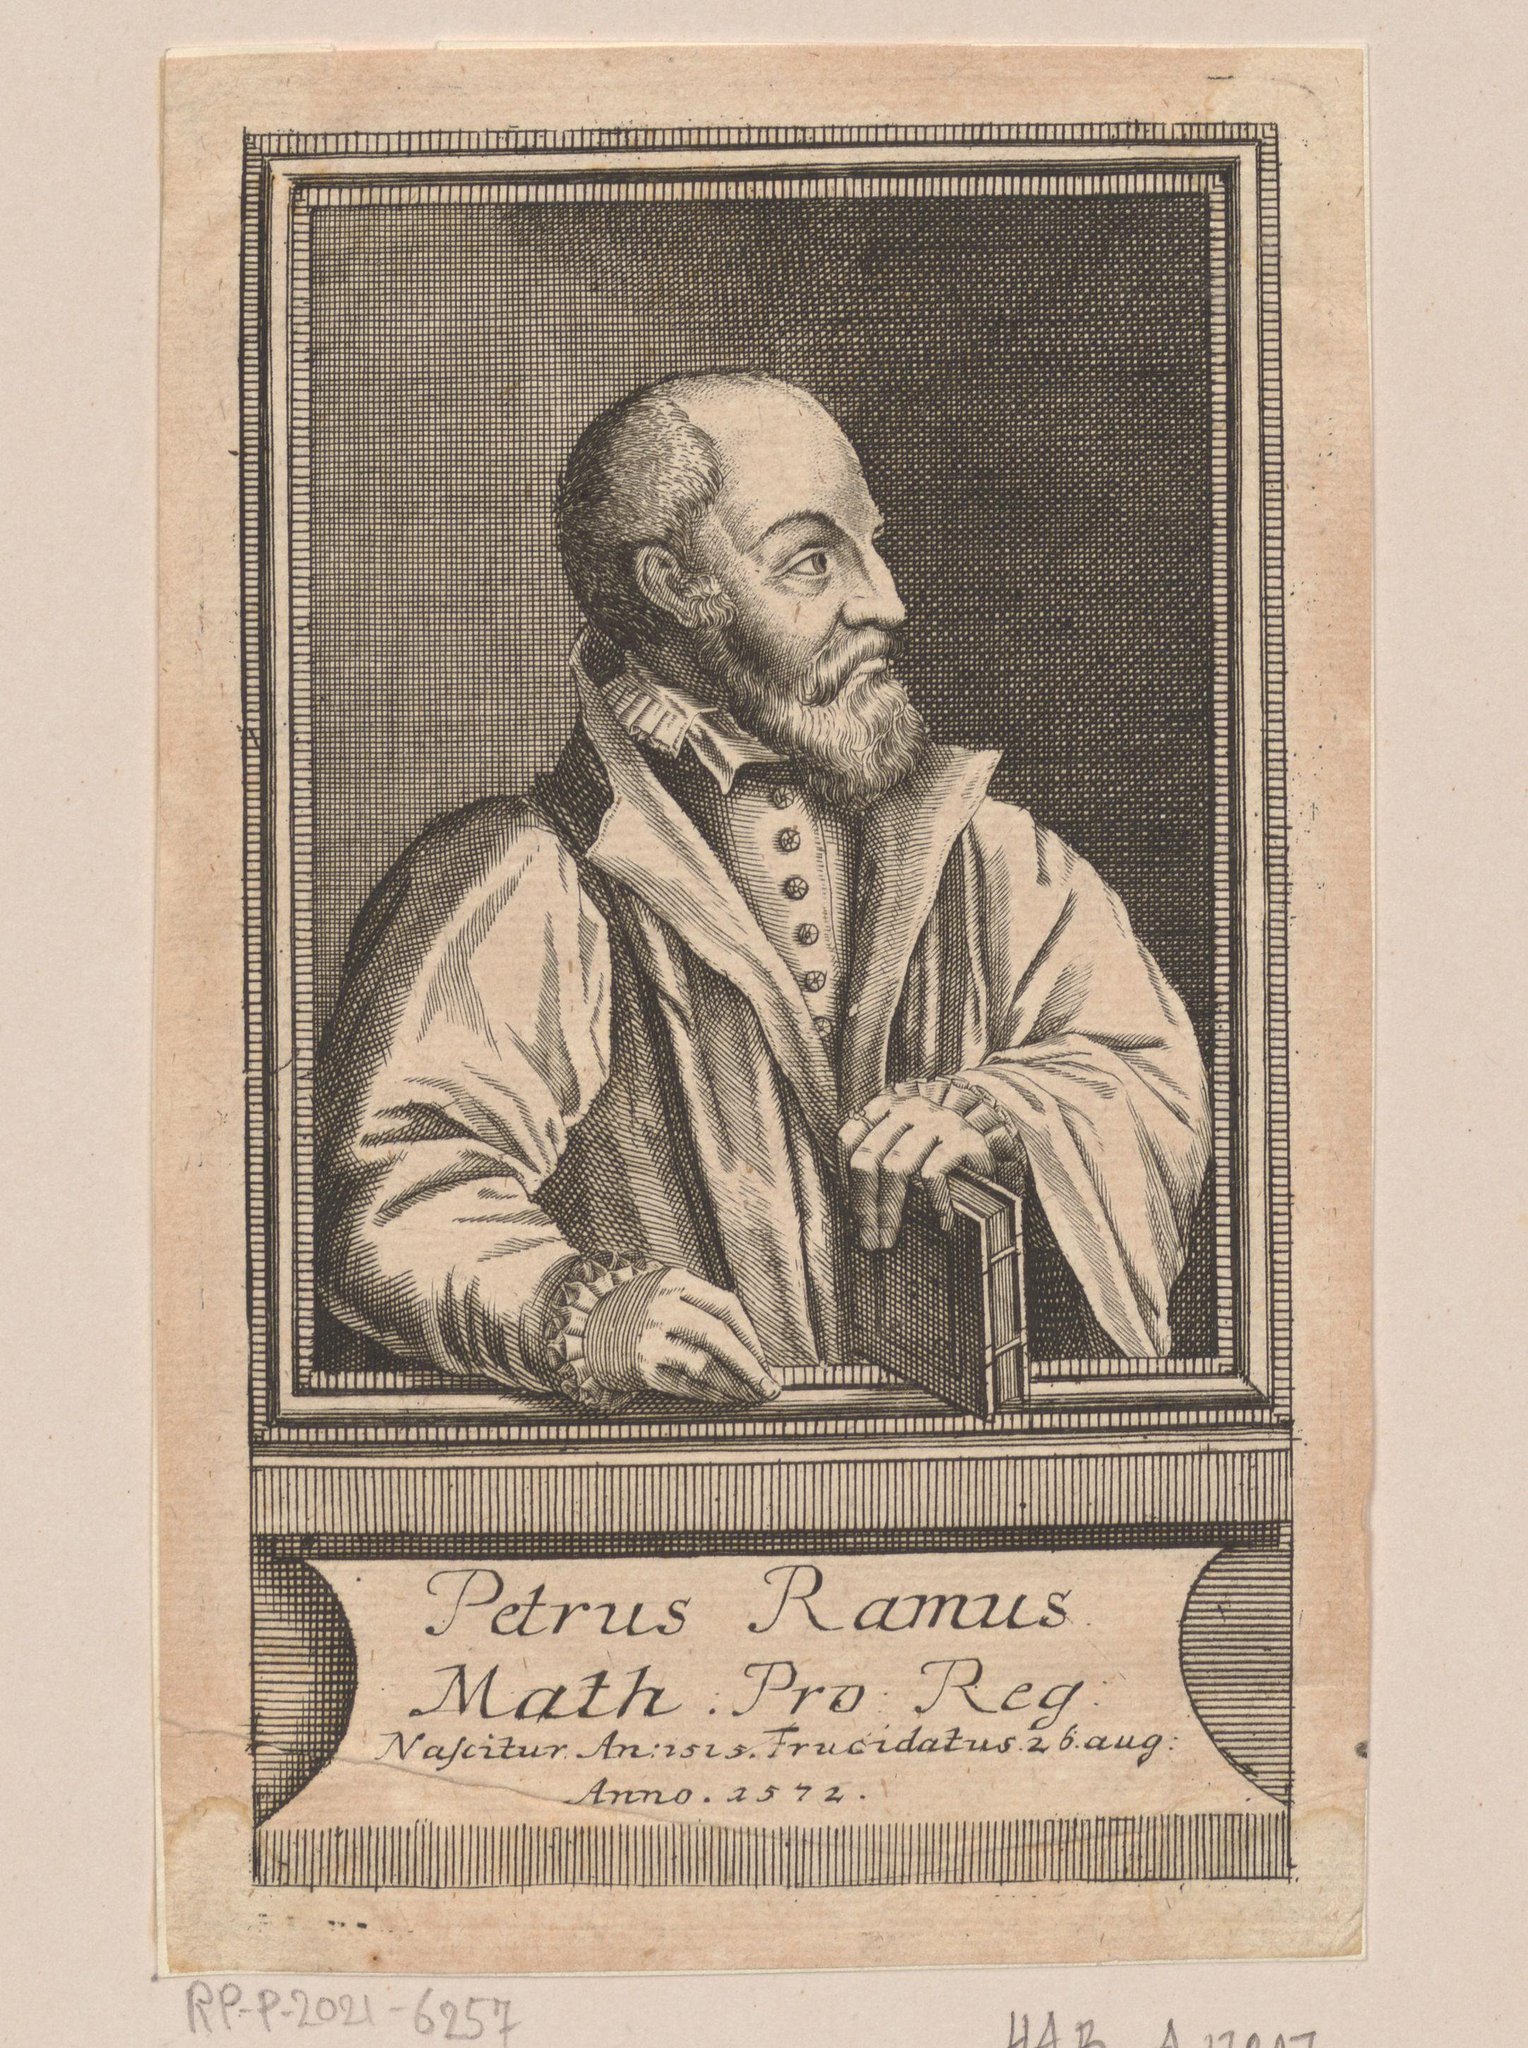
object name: print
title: Portret van Petrus Ramus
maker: Anonymous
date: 1700-1749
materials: paper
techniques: engraving, etching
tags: paris, historical persons, book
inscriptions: collector's mark: Lugt 2228